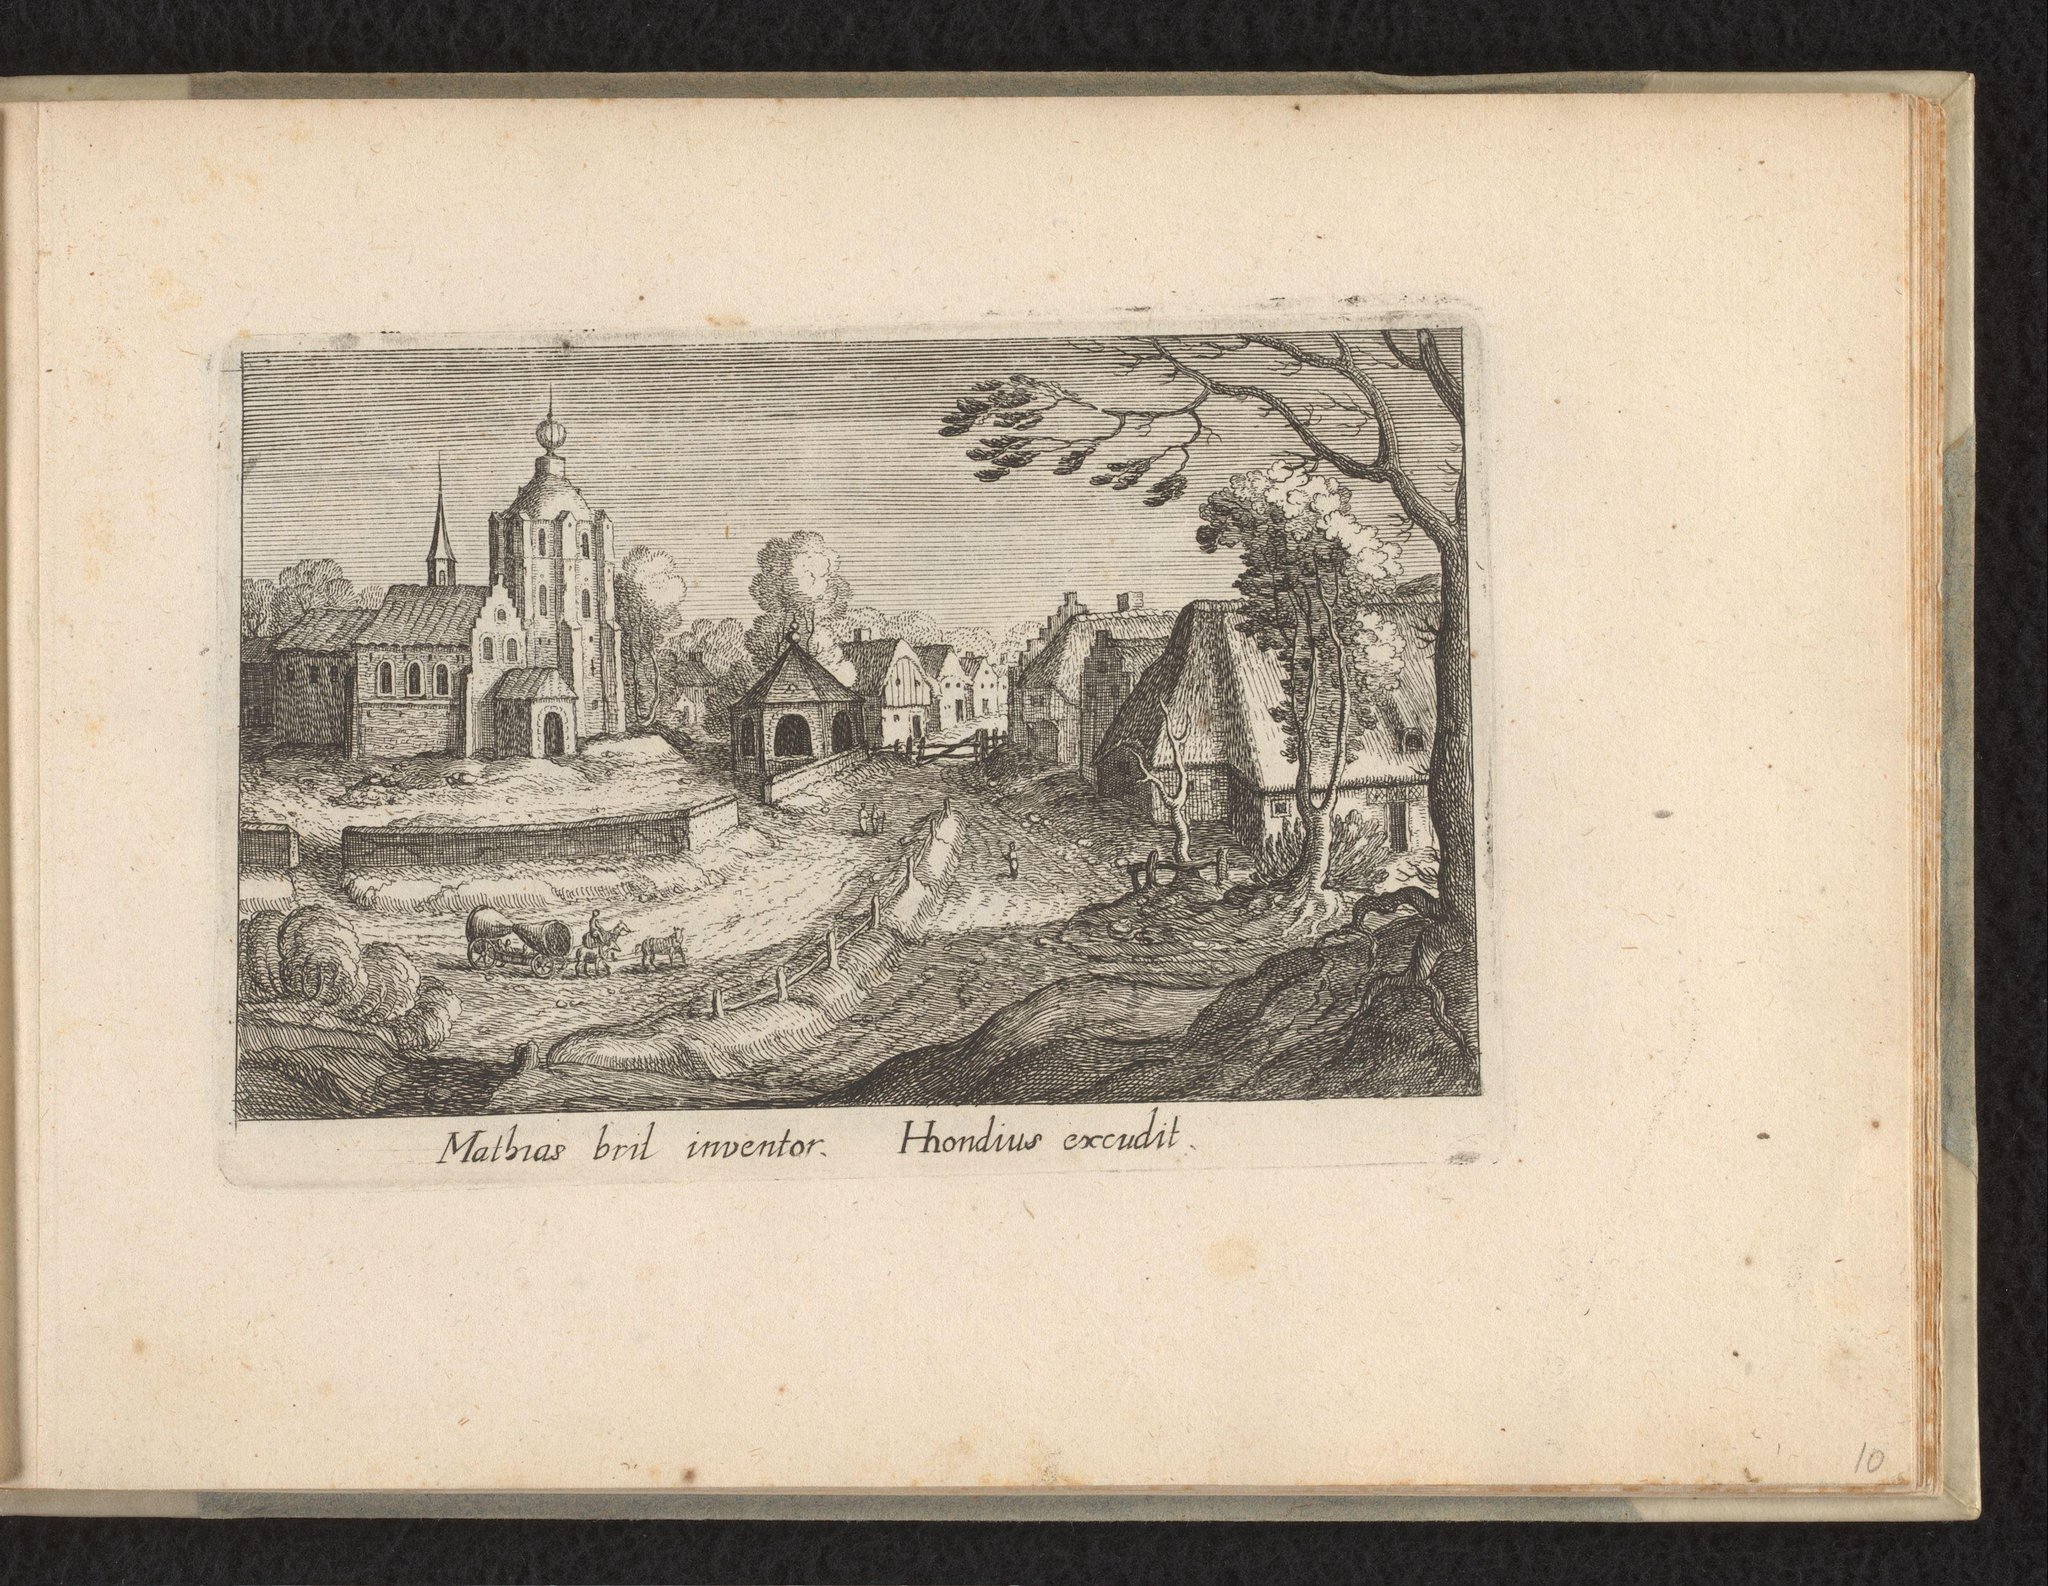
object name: print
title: Topographia Variarum Regionum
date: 1614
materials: paper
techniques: etching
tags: church (exterior), public road in village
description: Een landweg leidt naar een dorp met huizen en boerderijen. Links een grote kerk.